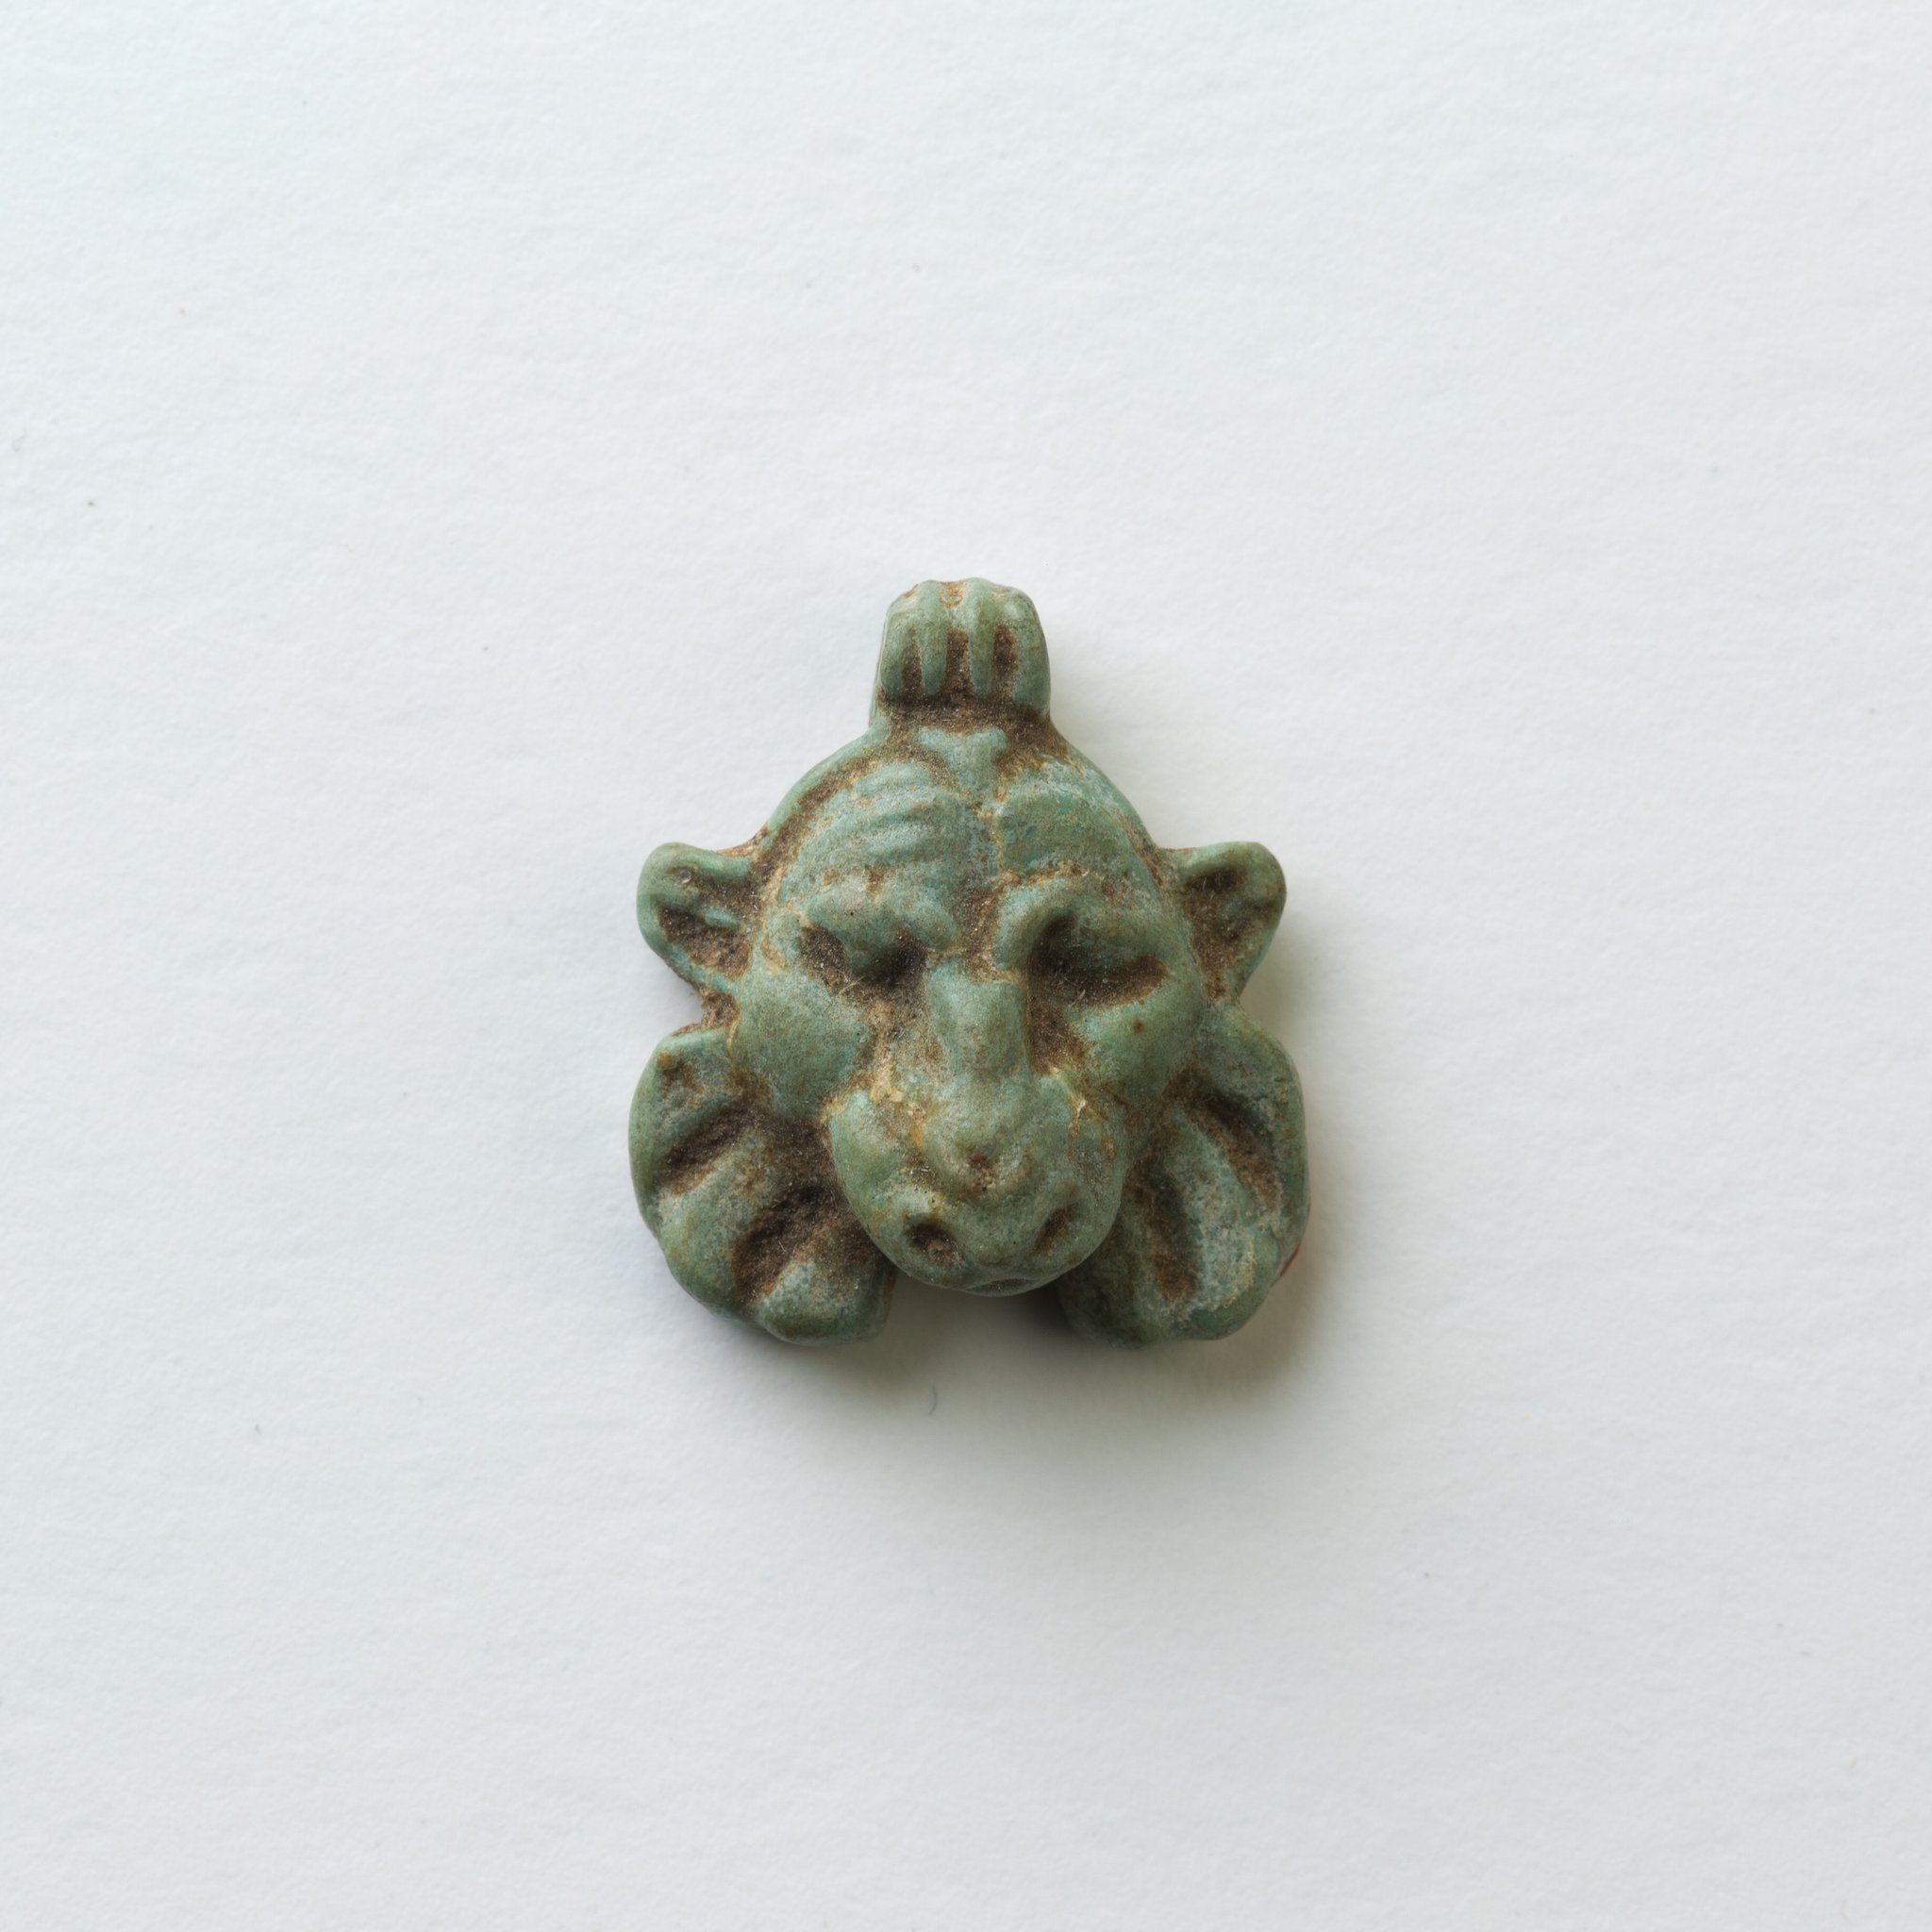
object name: amulet, lion head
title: Lion head amulet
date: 664-630 BCE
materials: faience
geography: egypt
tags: lions